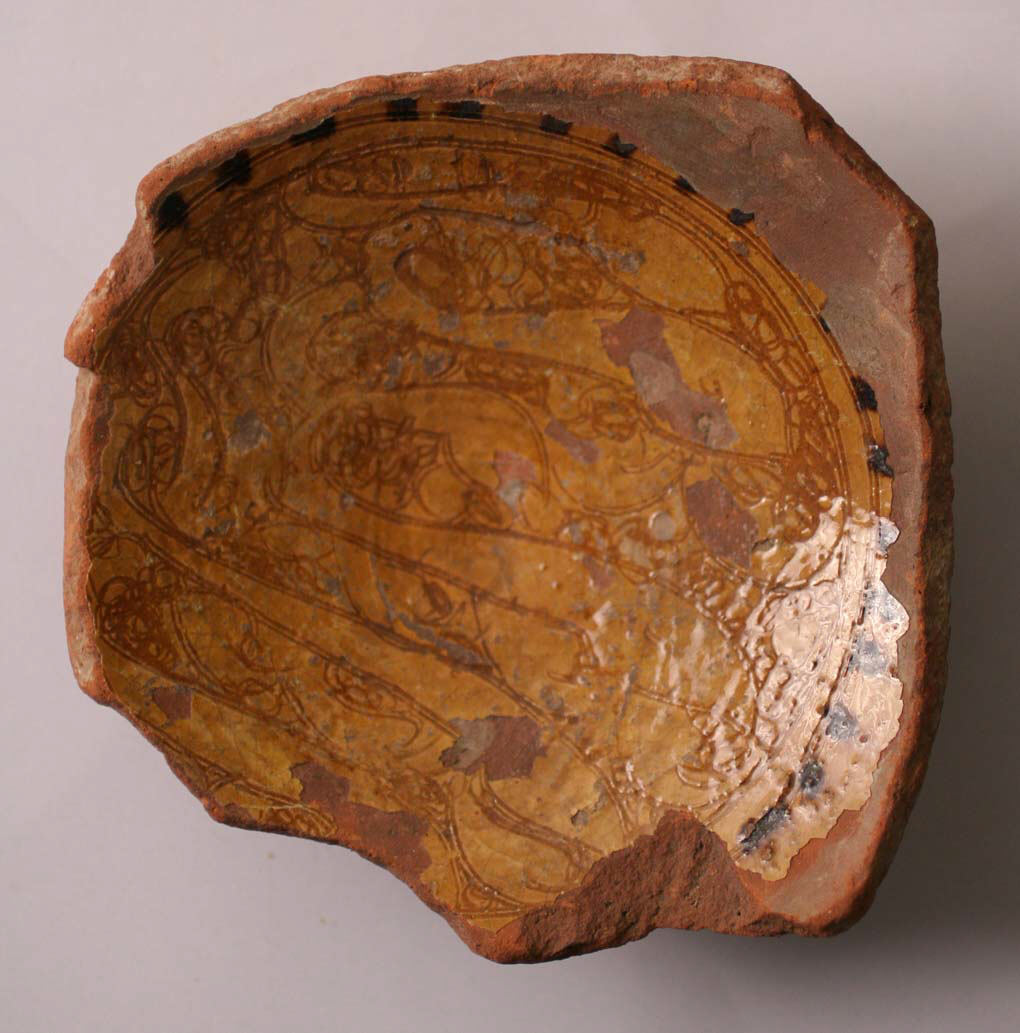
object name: fragment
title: Fragment of a Bowl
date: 1301-1500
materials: earthenware, glaze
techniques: coloring, incising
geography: egypt